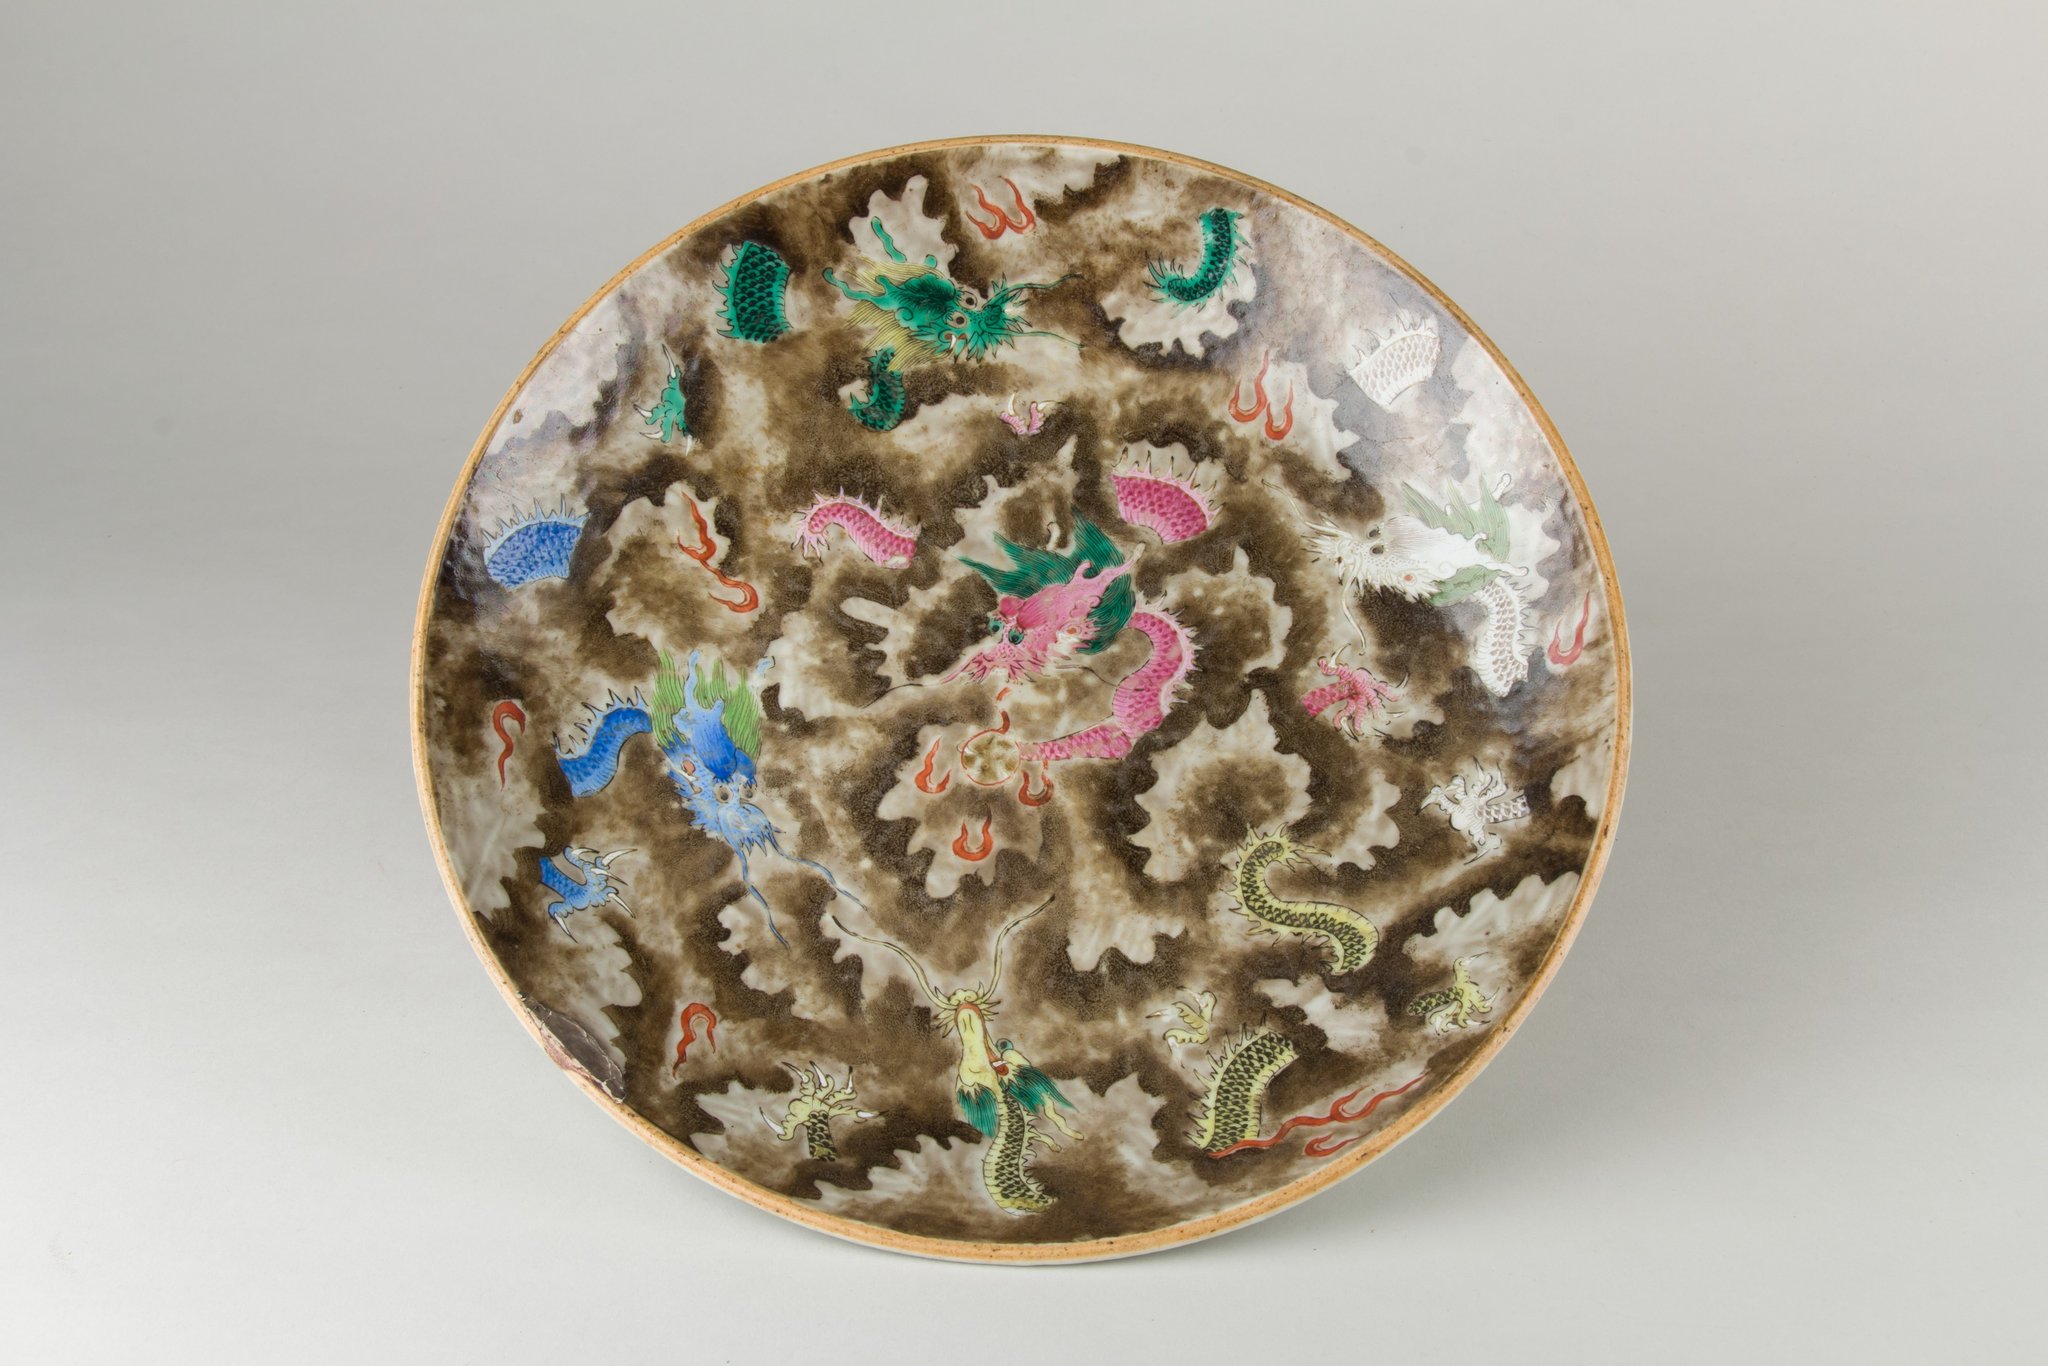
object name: dish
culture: chinese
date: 1801-1900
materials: enamel, porcelain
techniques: overglaze, painting, polychrome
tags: dragons